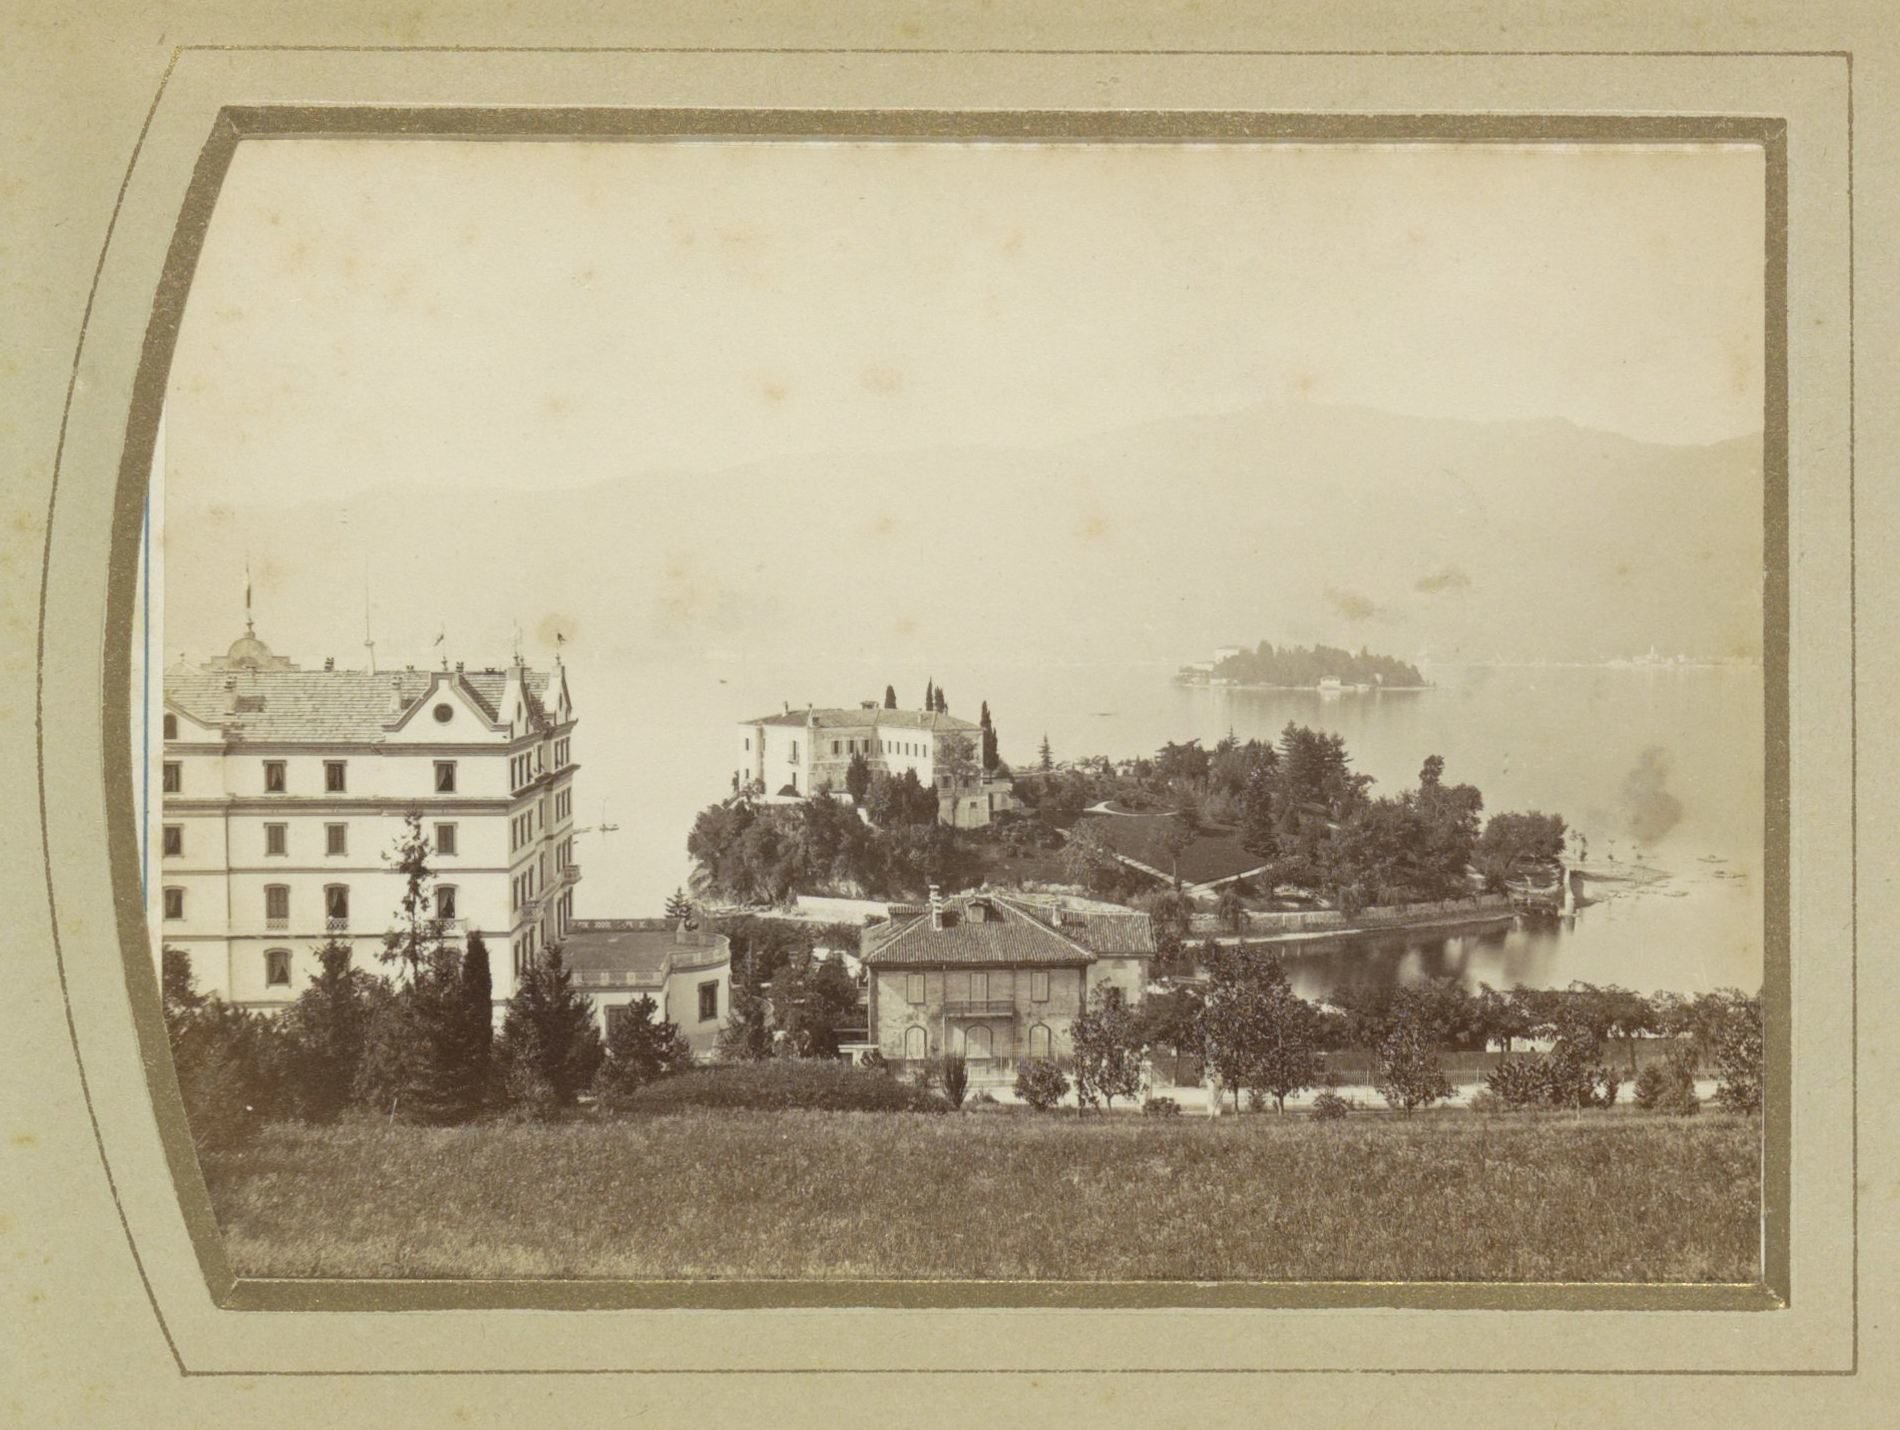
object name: cabinet photograph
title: Gezicht op het Lago Maggiore en het Isolino di San Giovanni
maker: alfredo noack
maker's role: fotograaf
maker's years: 1833-1895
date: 1870-1890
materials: cardboard, paper, photographic support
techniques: albumen print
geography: italy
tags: prospect of village, silhouette of village, island, italy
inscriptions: address: ‘Vico del Filo No. 1 Genova’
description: Onderdeel van Fotoalbum van de familie Boelen.